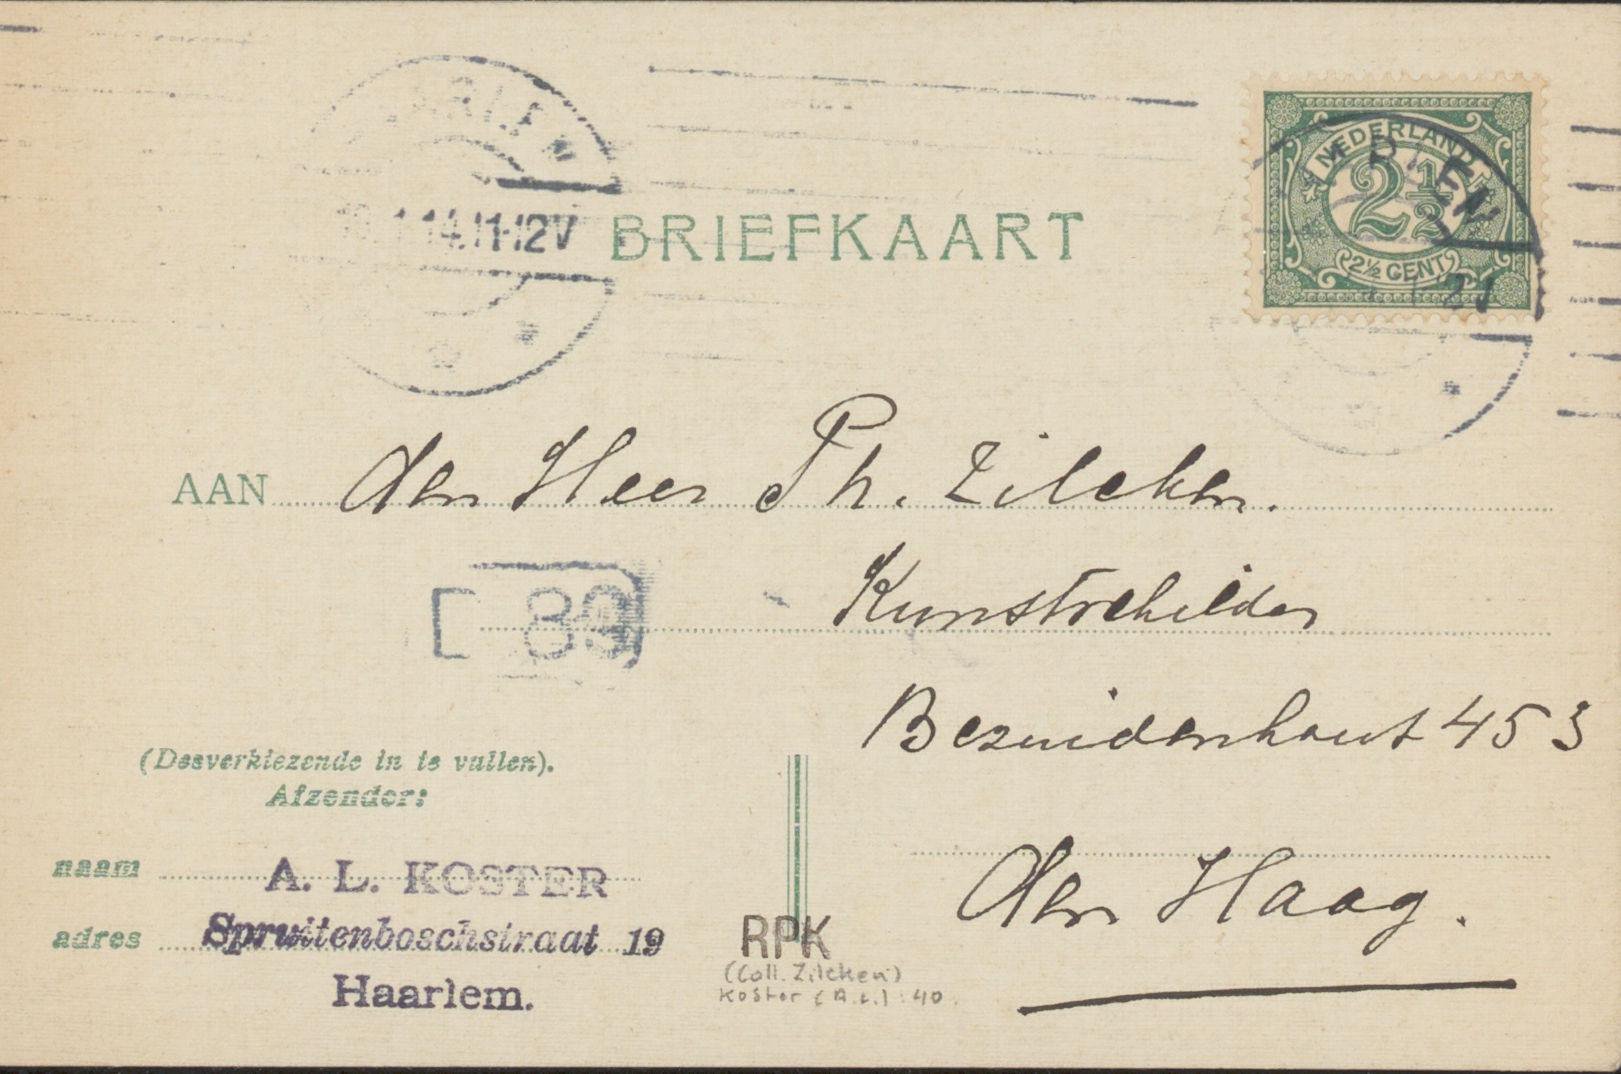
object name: postcard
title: Briefkaart aan Philip Zilcken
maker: anton l. koster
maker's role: draughtsman, painter, print maker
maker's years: 1859-1937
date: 1914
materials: cardboard, ink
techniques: pen, writing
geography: haarlem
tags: dagmar frandsen, the hague, painter, draughtsman, philip zilcken, the graphic arts, copenhagen (city)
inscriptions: collector's mark: ‘RPK’, address: ‘A.L. KOSTER/ Spruitenboschstraat 19/ Haarlem.’